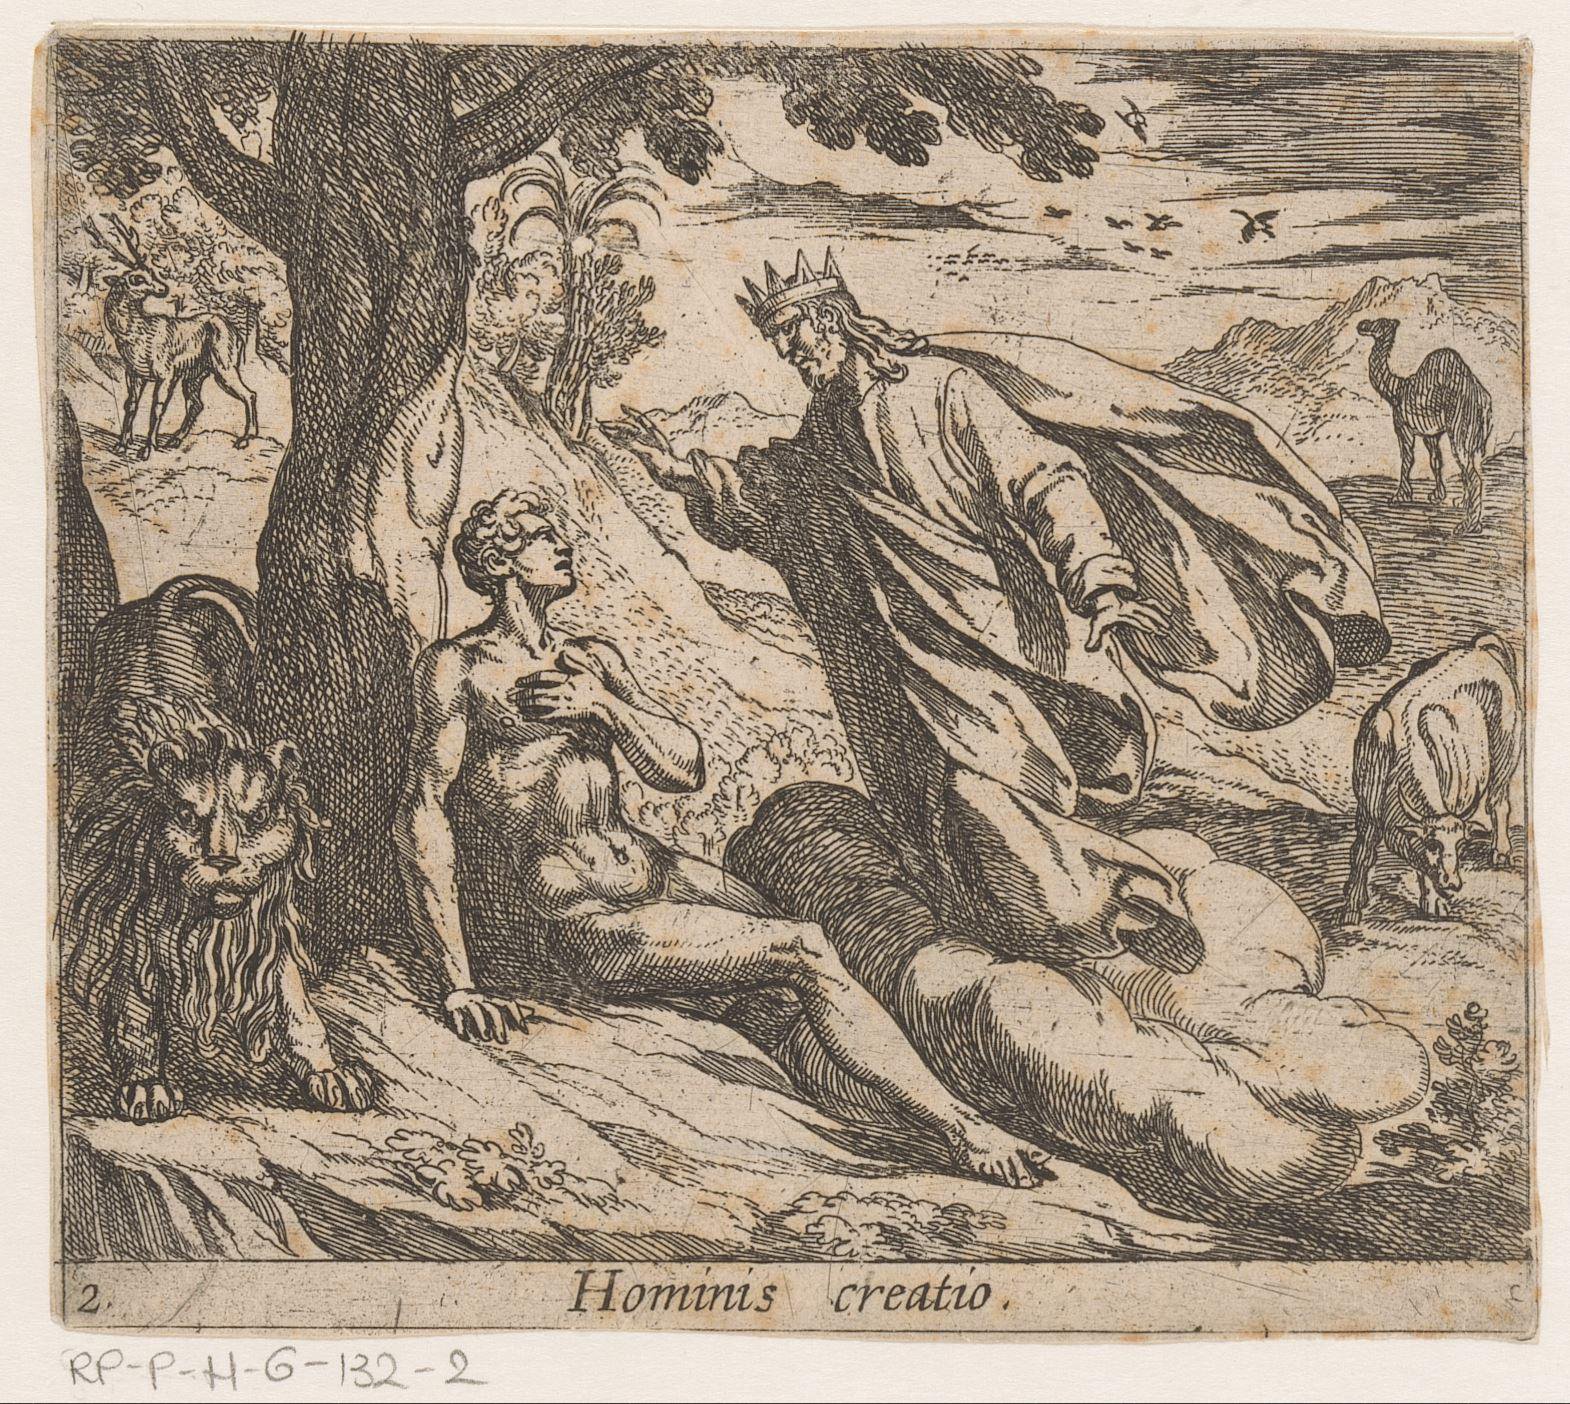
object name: print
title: Hominis creatio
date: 1606-1638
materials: paper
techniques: etching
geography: amsterdam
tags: creation of man by some creative force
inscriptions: collector's mark: ‘Hinloopen’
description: God op een wolk in een landschap. Hij schept een man onder een boom. Rondom staan verschillende dieren. Titel in het Latijn in ondermarge.